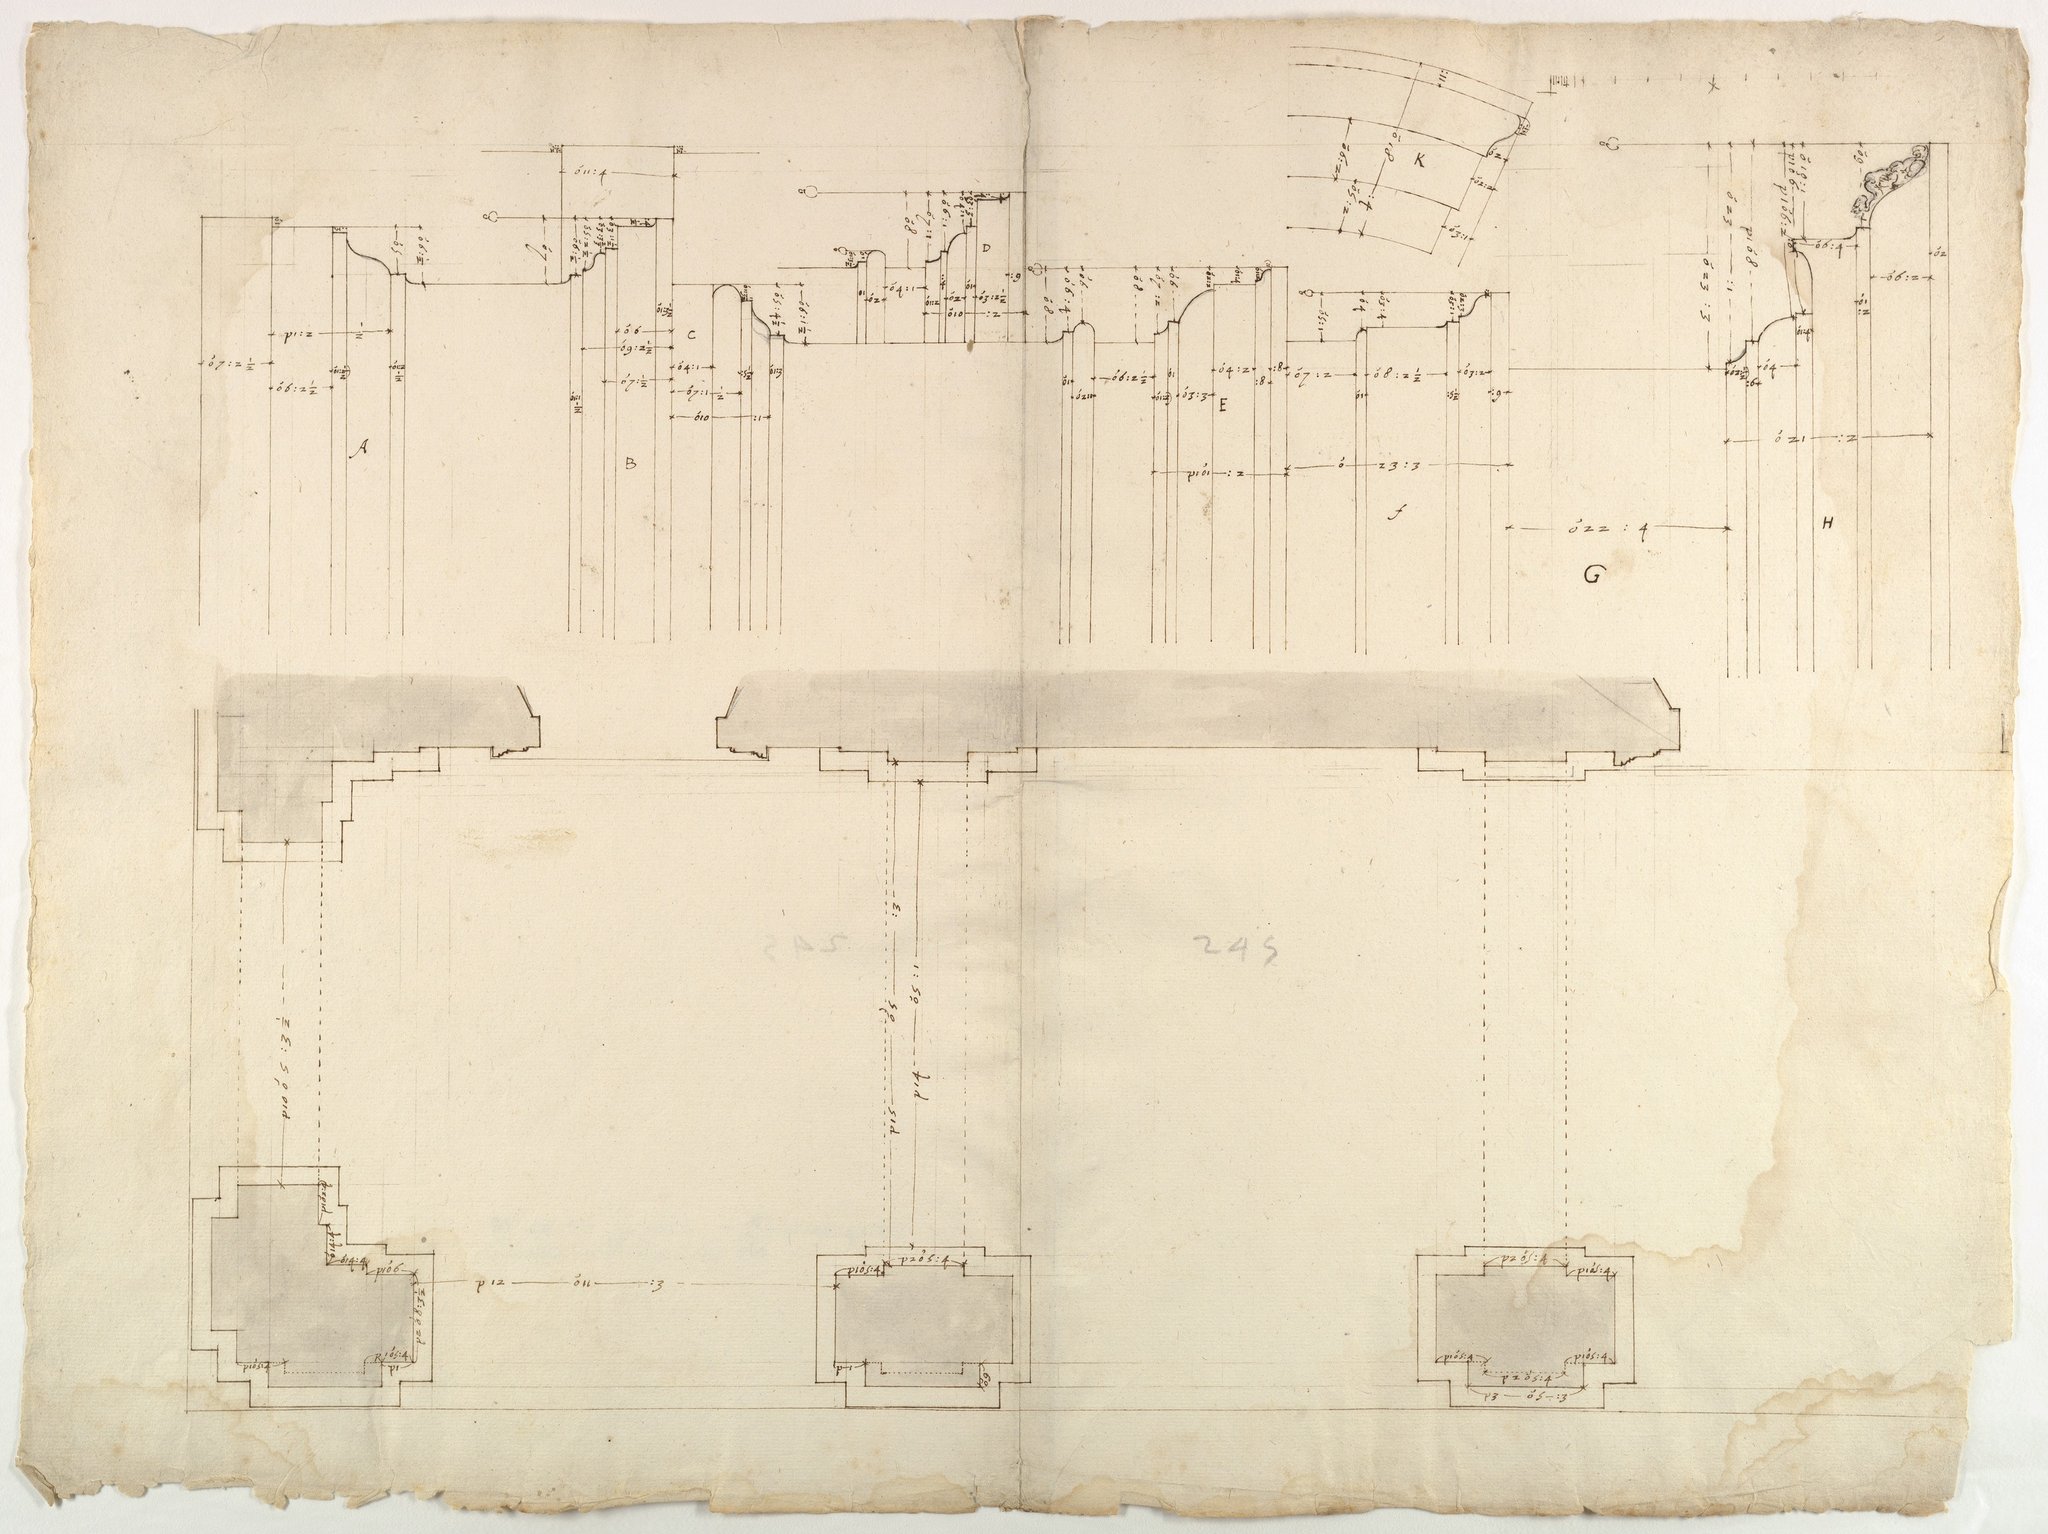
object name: drawing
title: S. Maria in Domnica, portico, plan; details, profile (recto) blank (verso)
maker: anonymous, french, 16th century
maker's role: draftsman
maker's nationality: french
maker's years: 1500-1600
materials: chalk, ink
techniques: incising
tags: architecture